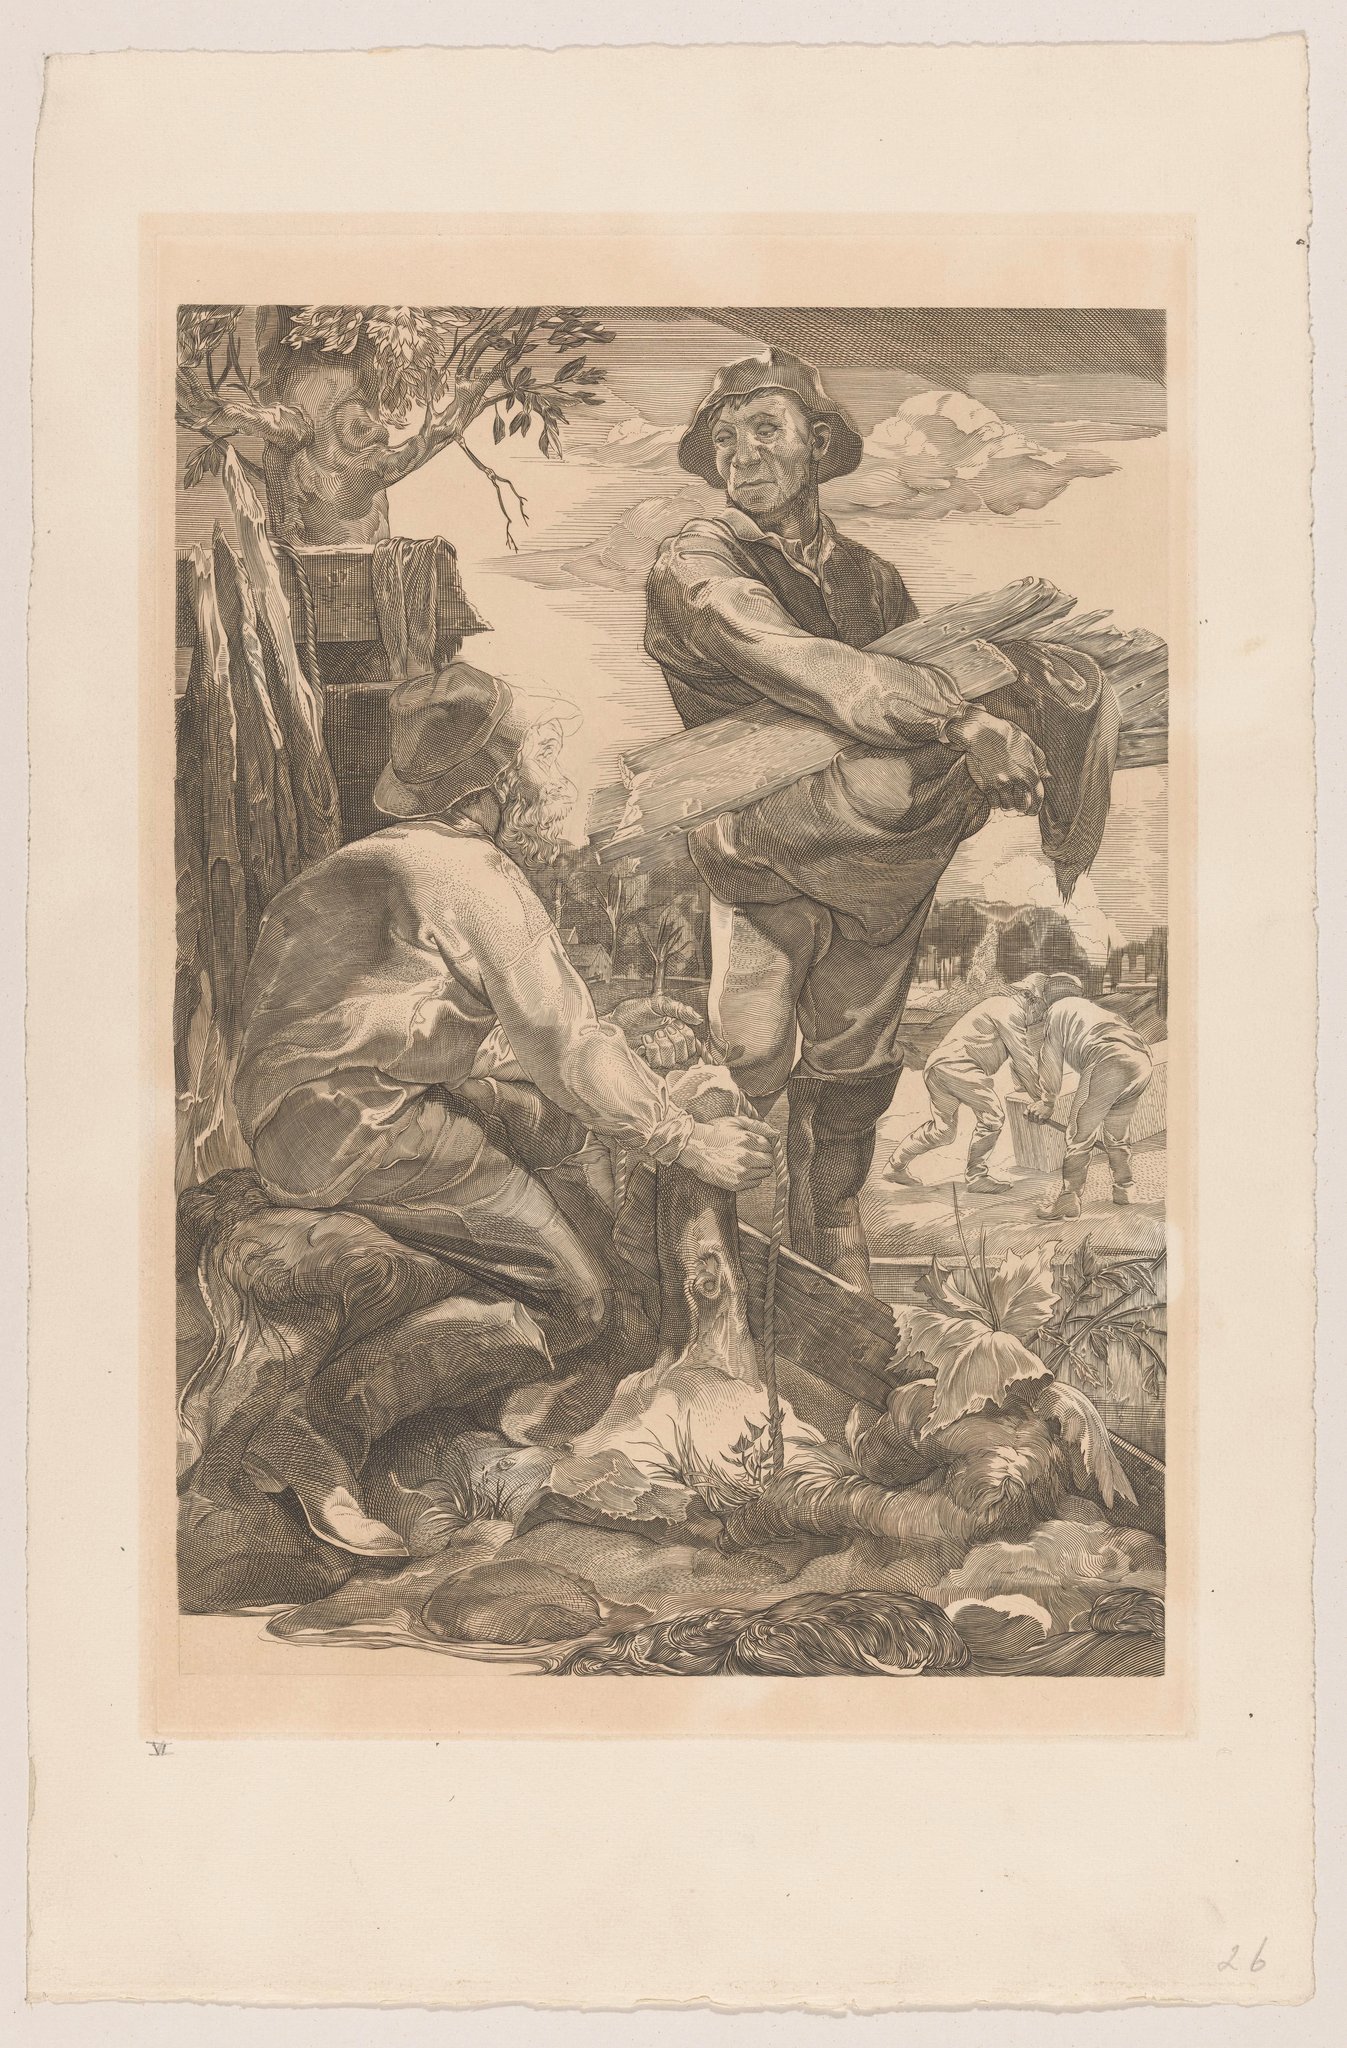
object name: print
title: Twee arbeiders met touw en planken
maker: johannes josephus aarts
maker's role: draughtsman, print maker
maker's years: 1871-1934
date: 1881-1934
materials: paper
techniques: engraving, intaglio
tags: plank, board ~ building material, working class, labourers, tools, aids, implements ~ crafts and industries: rope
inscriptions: collector's mark: Lugt 2166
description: Twee arbeiders met hoed, waarvan één zittend en de ander staand. De zittende man bindt een touw om een boomstam. De staande man houdt een stapel afbraakhout vast. Op de achtergrond wrikken twee arbeiders met een staaf onder een rechthoekig object.